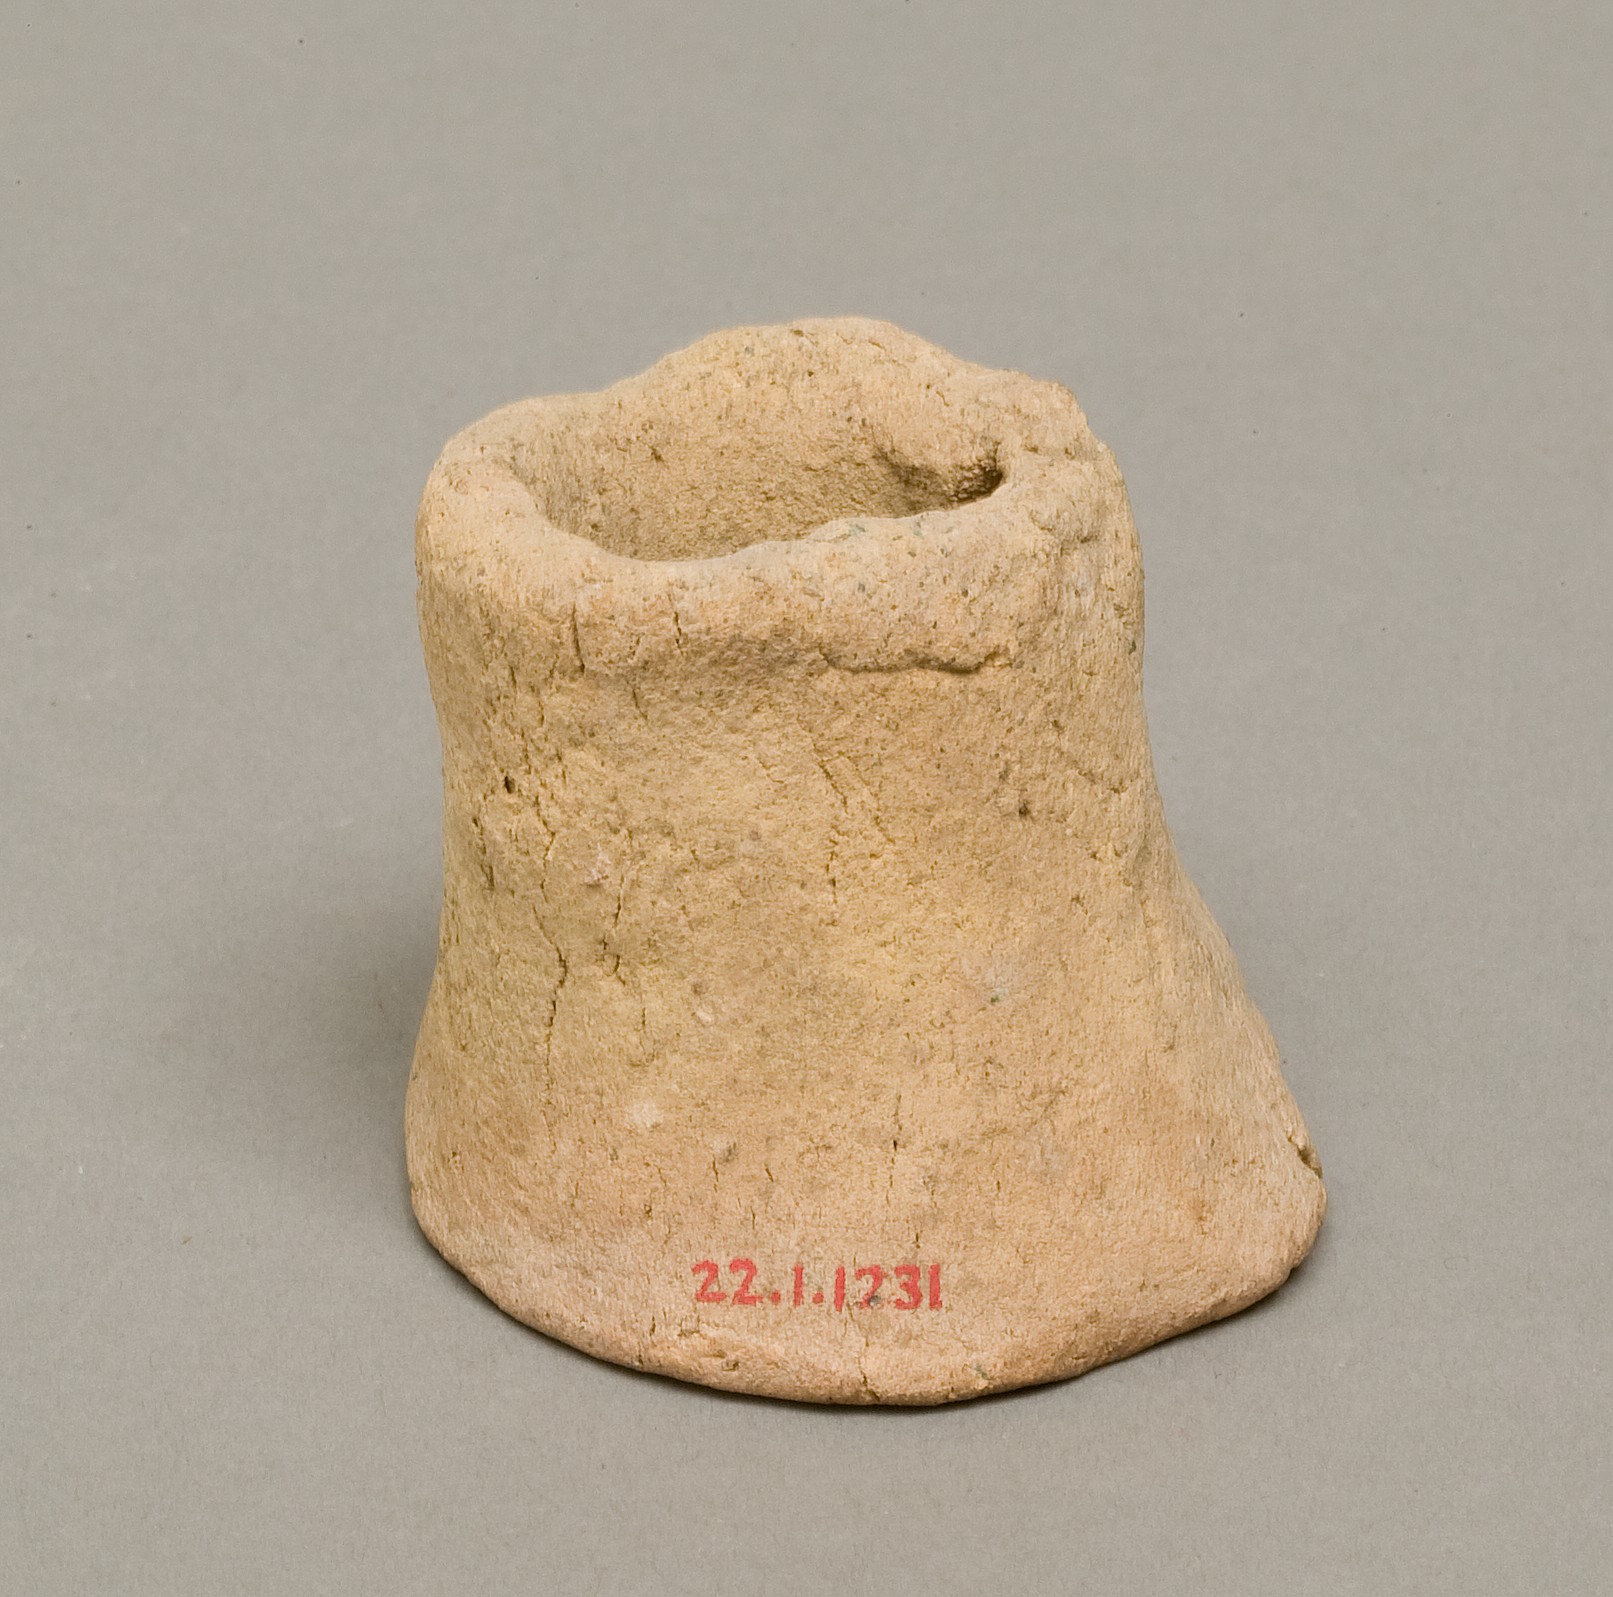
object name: fragment, clay section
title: Faience workshop refuse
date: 1802-1450 BCE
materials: clay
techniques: firing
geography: egypt